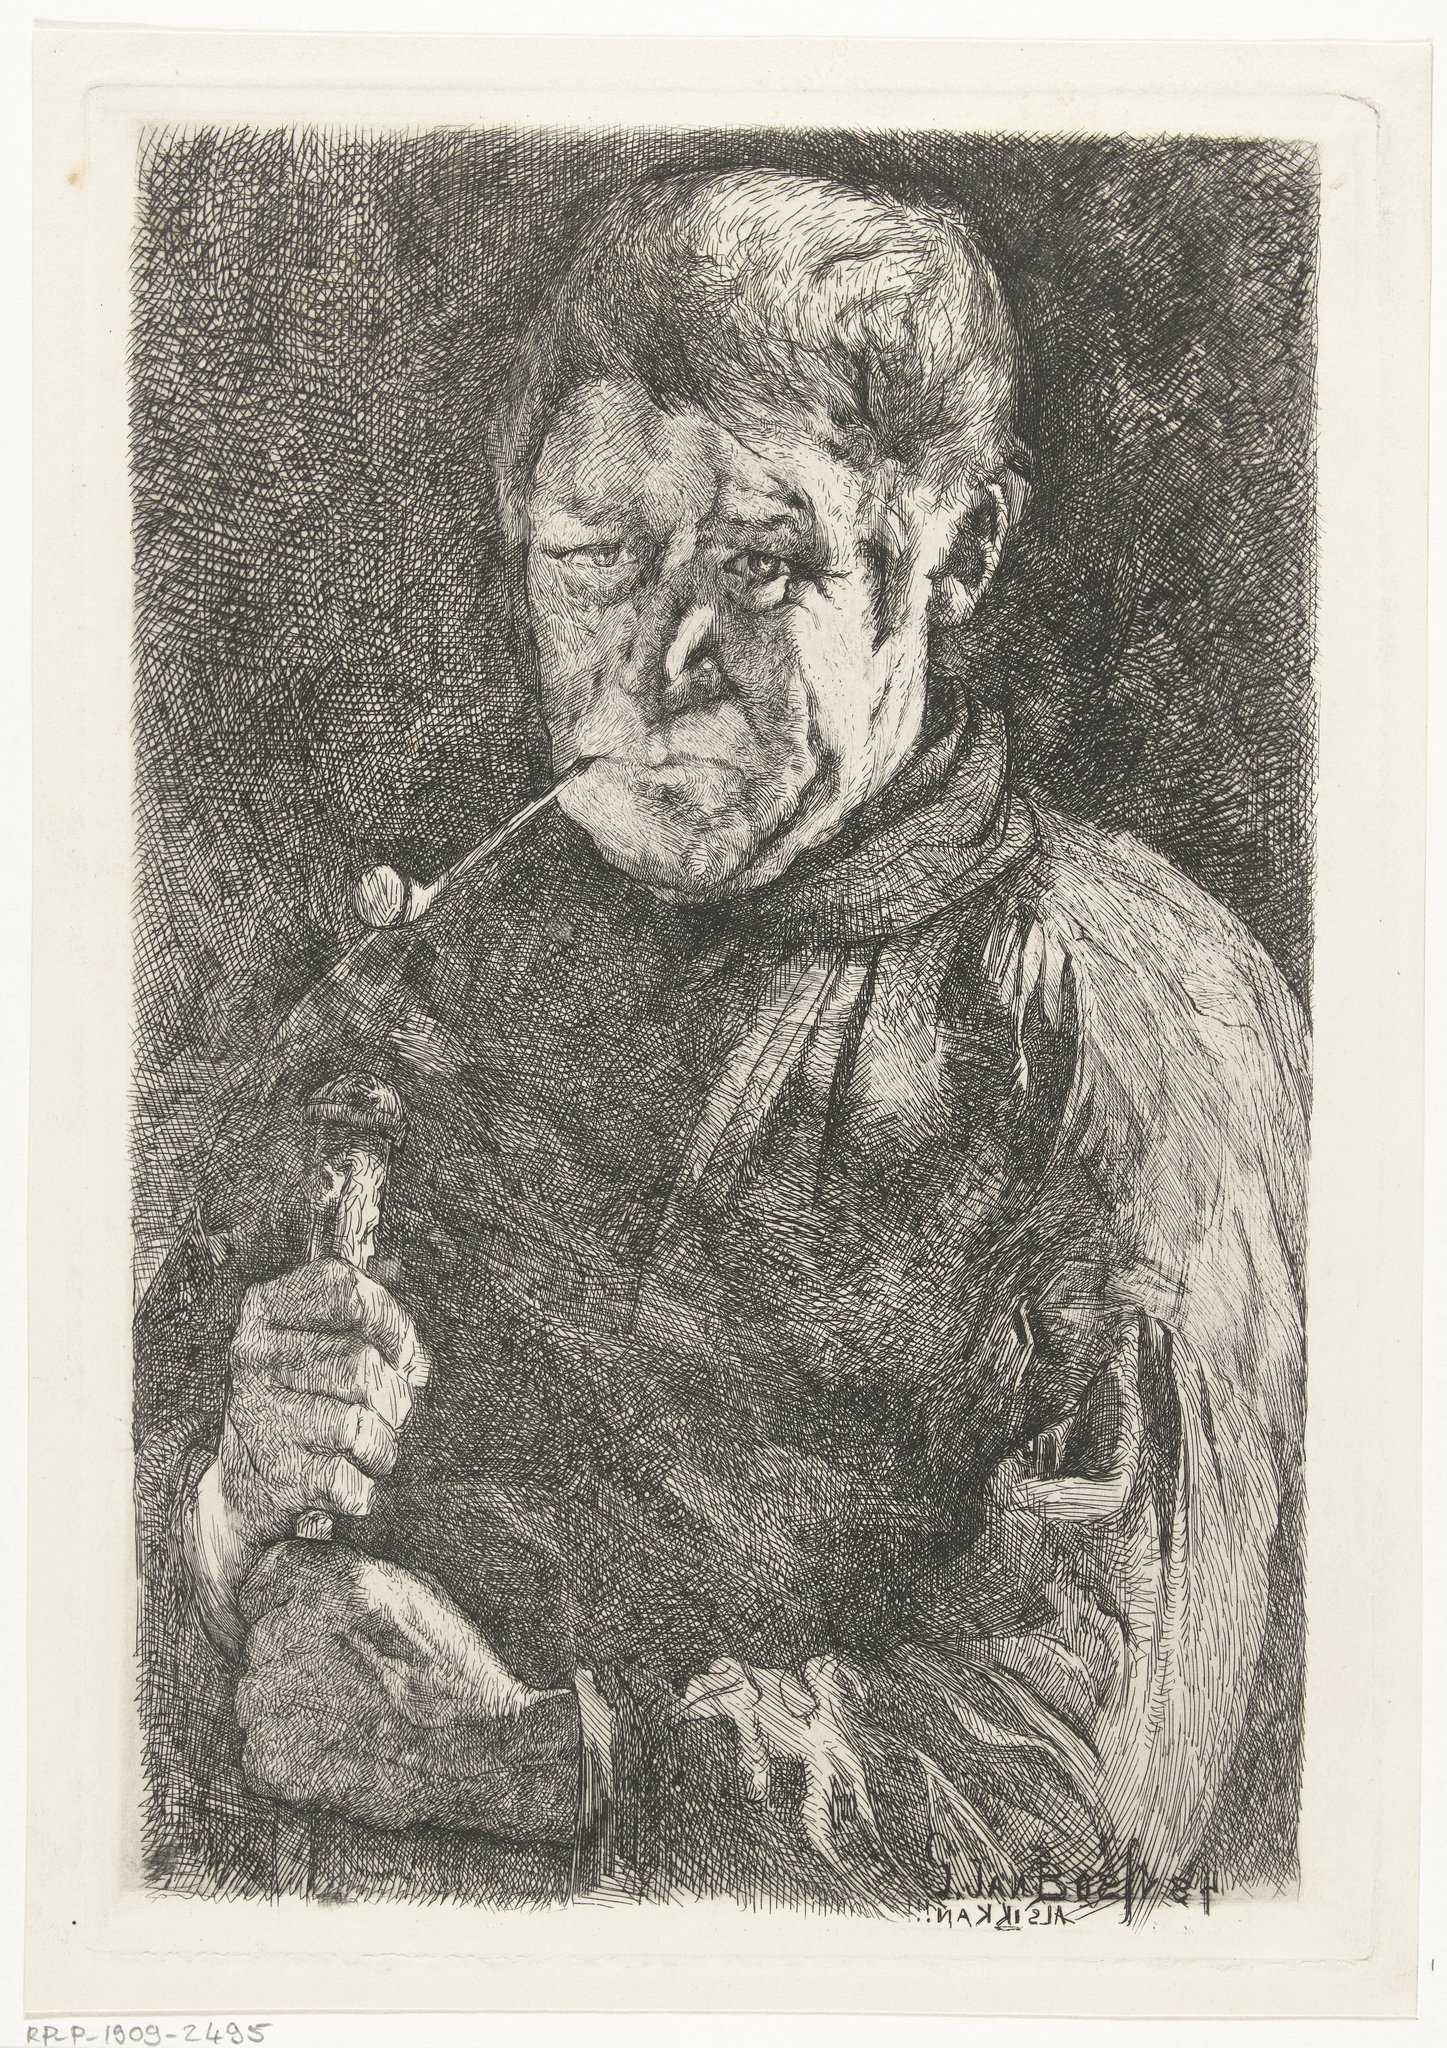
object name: print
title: Man met pijp en wandelstok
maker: gerard jan bos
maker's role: print maker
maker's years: 1860-1943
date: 1884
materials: paper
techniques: etching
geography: antwerp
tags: pipe ~ tobacco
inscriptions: collector's mark: Lugt 2228